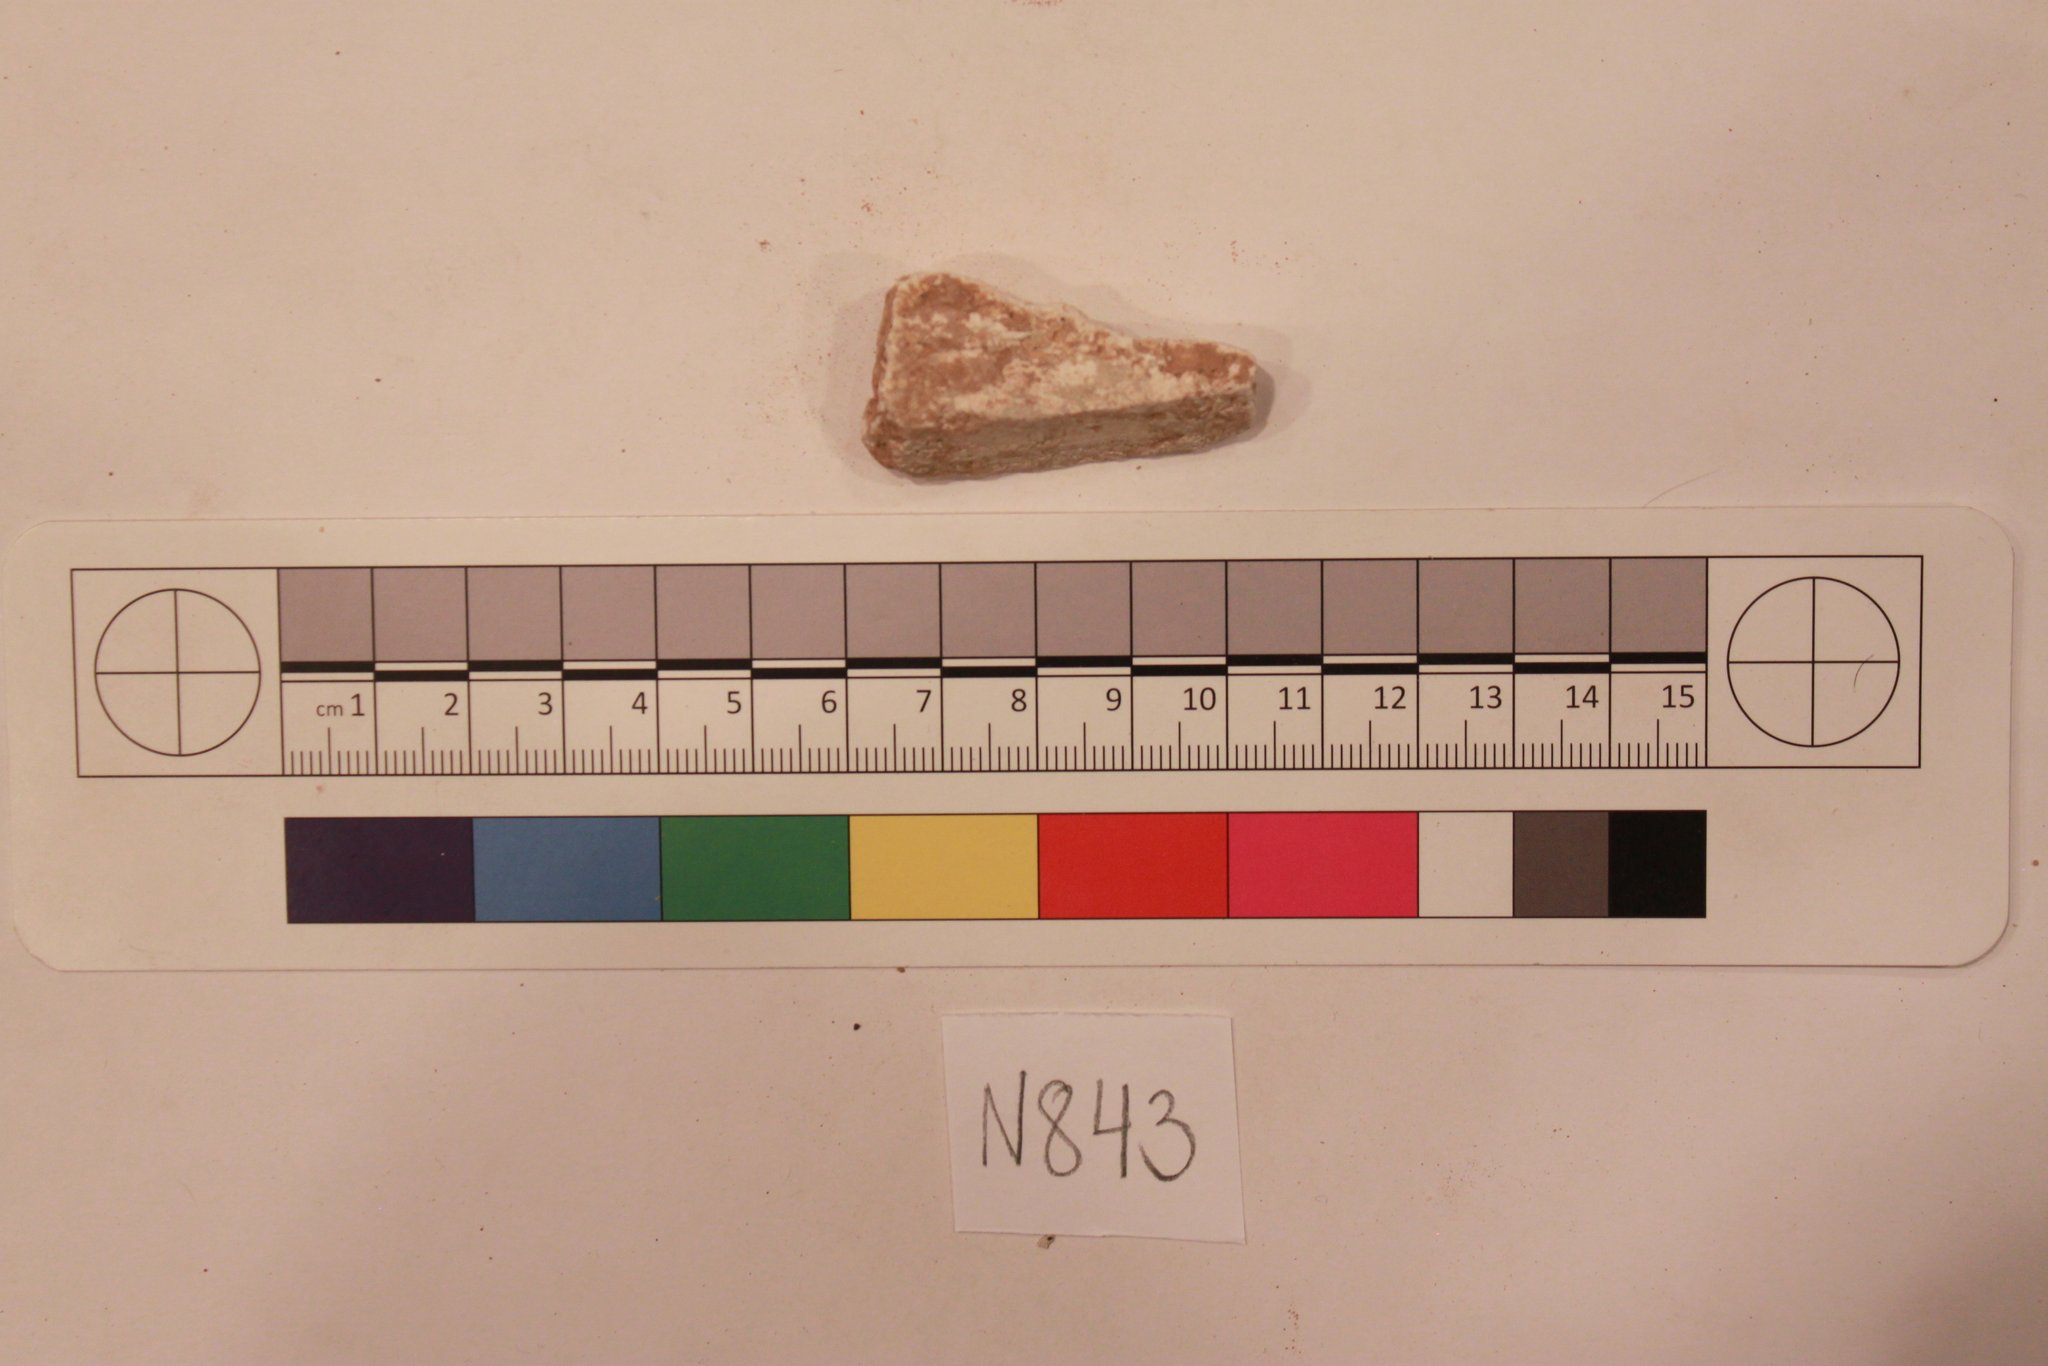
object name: fragment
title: Stucco Fragment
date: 701-1200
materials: plaster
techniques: carving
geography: iran